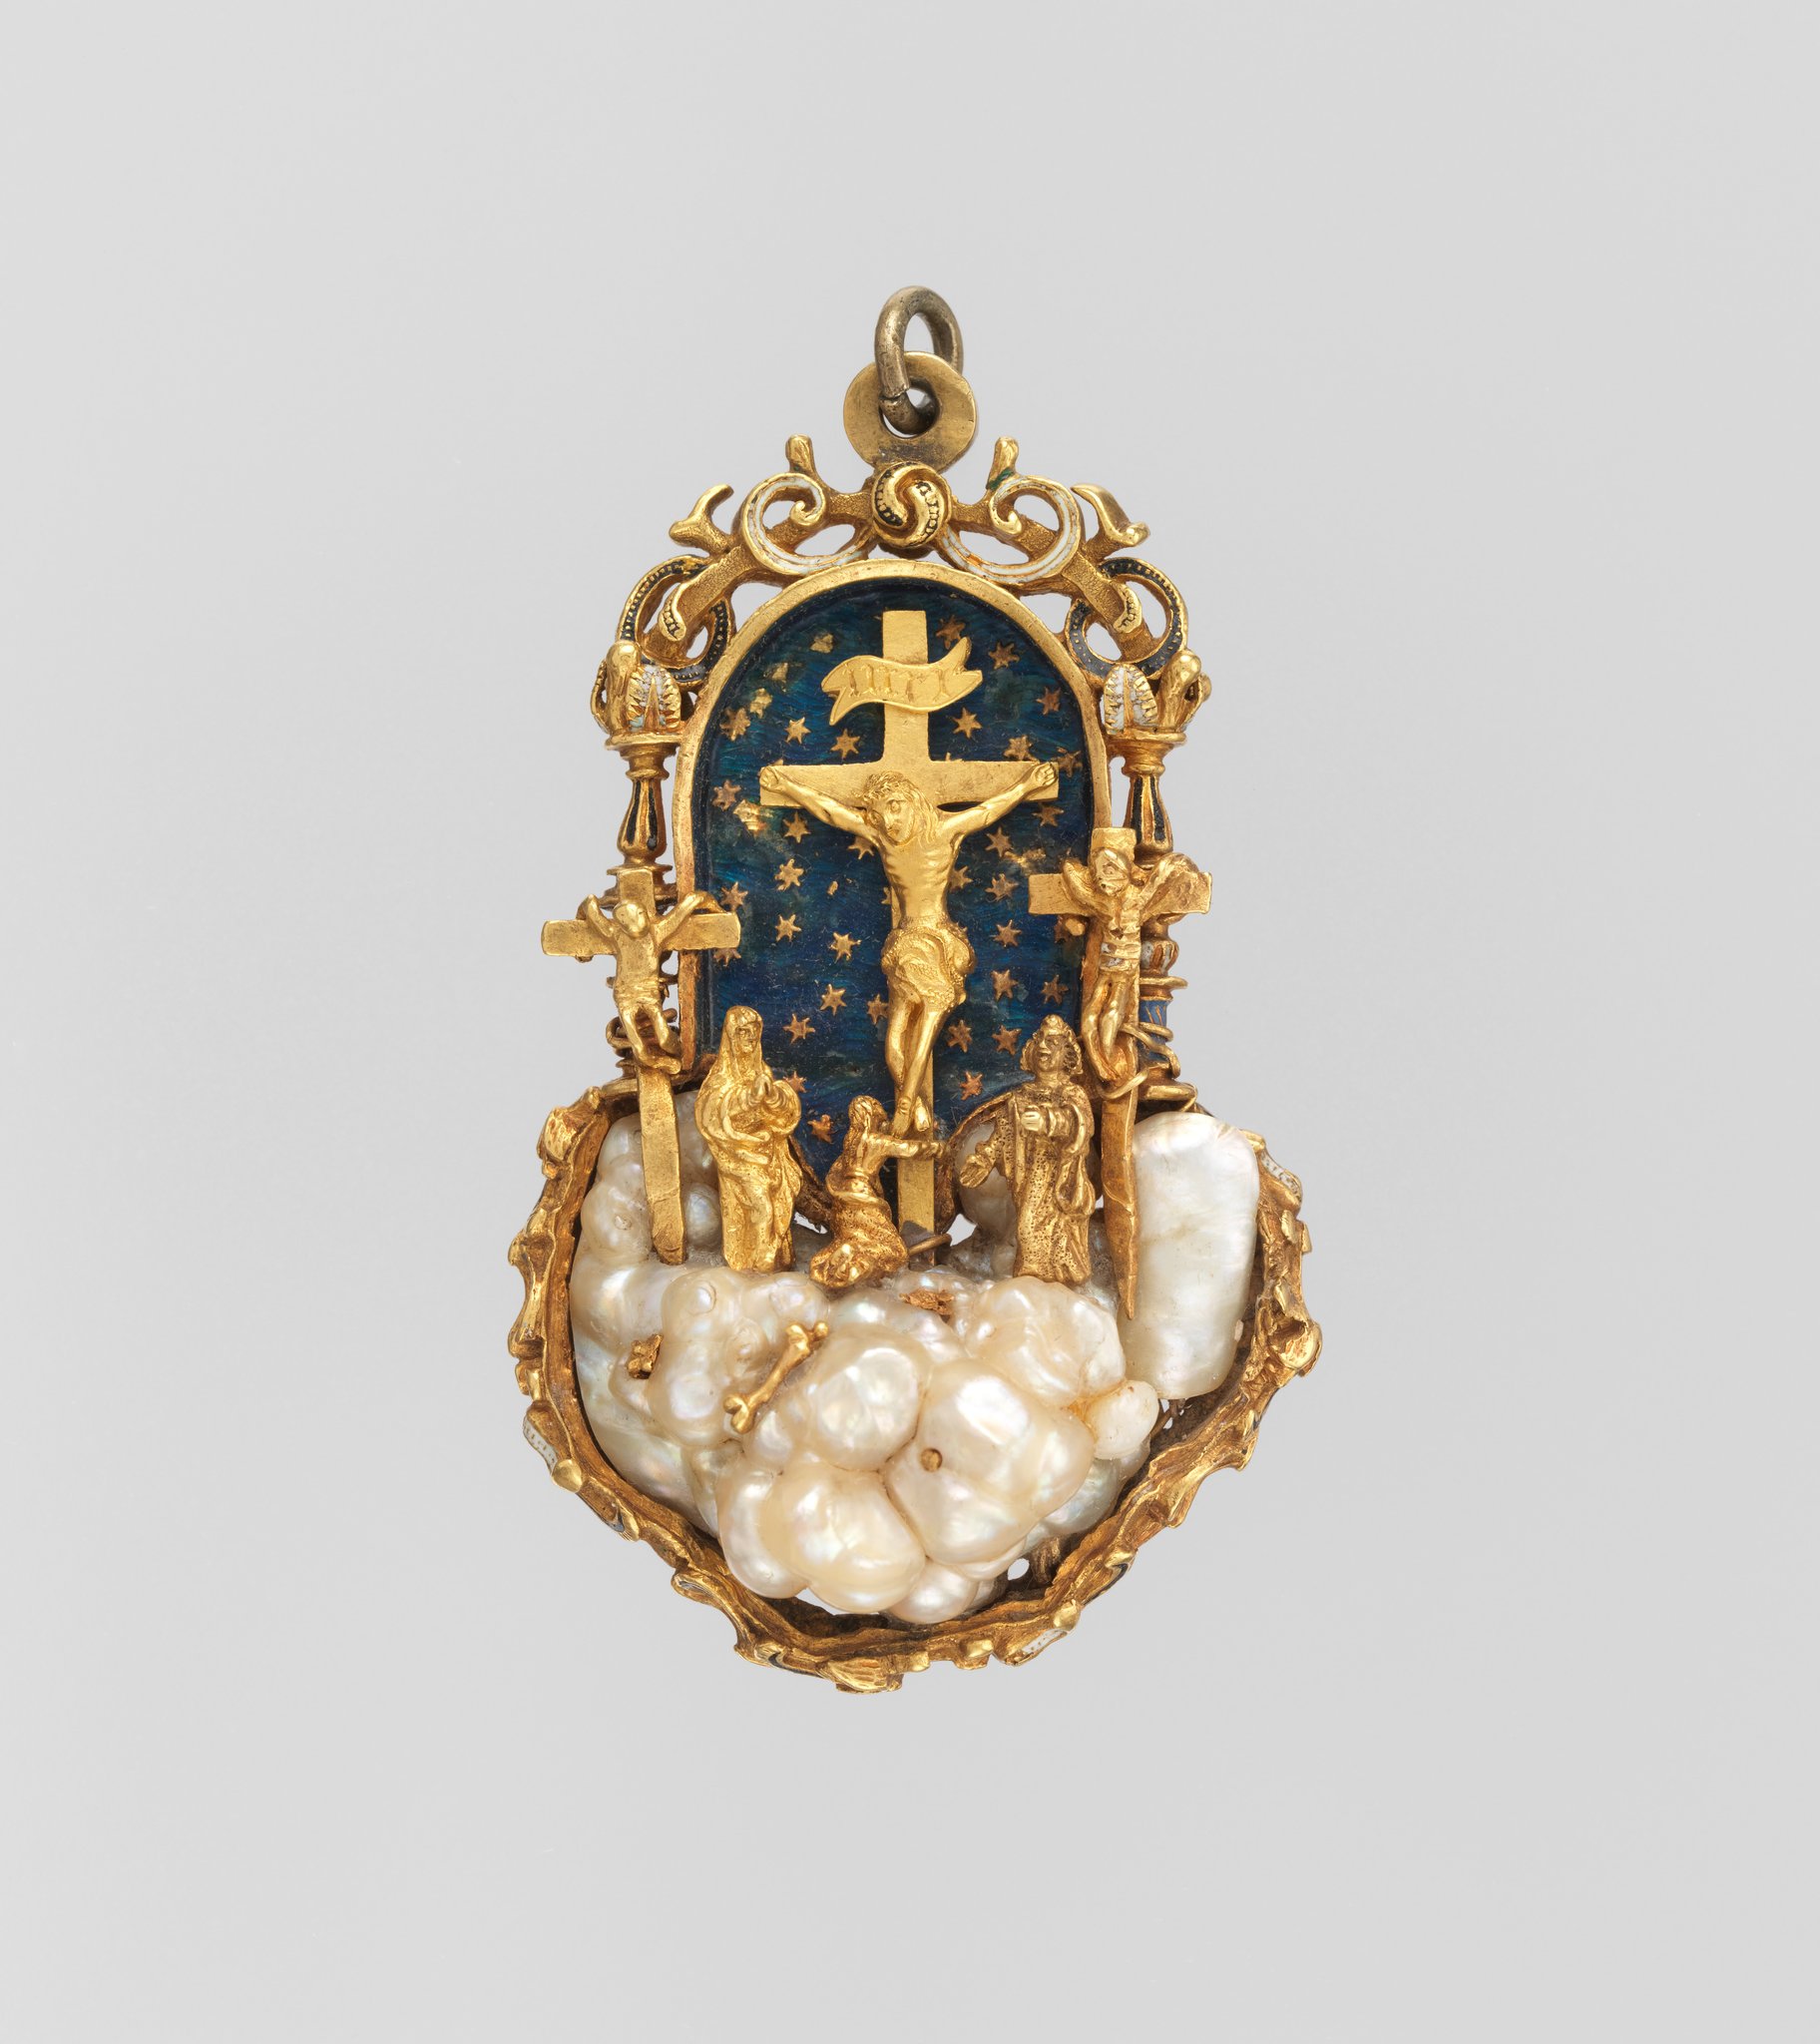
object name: pendant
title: The Crucifixion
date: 1601-1650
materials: gold, pearl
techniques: enamel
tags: crucifixion